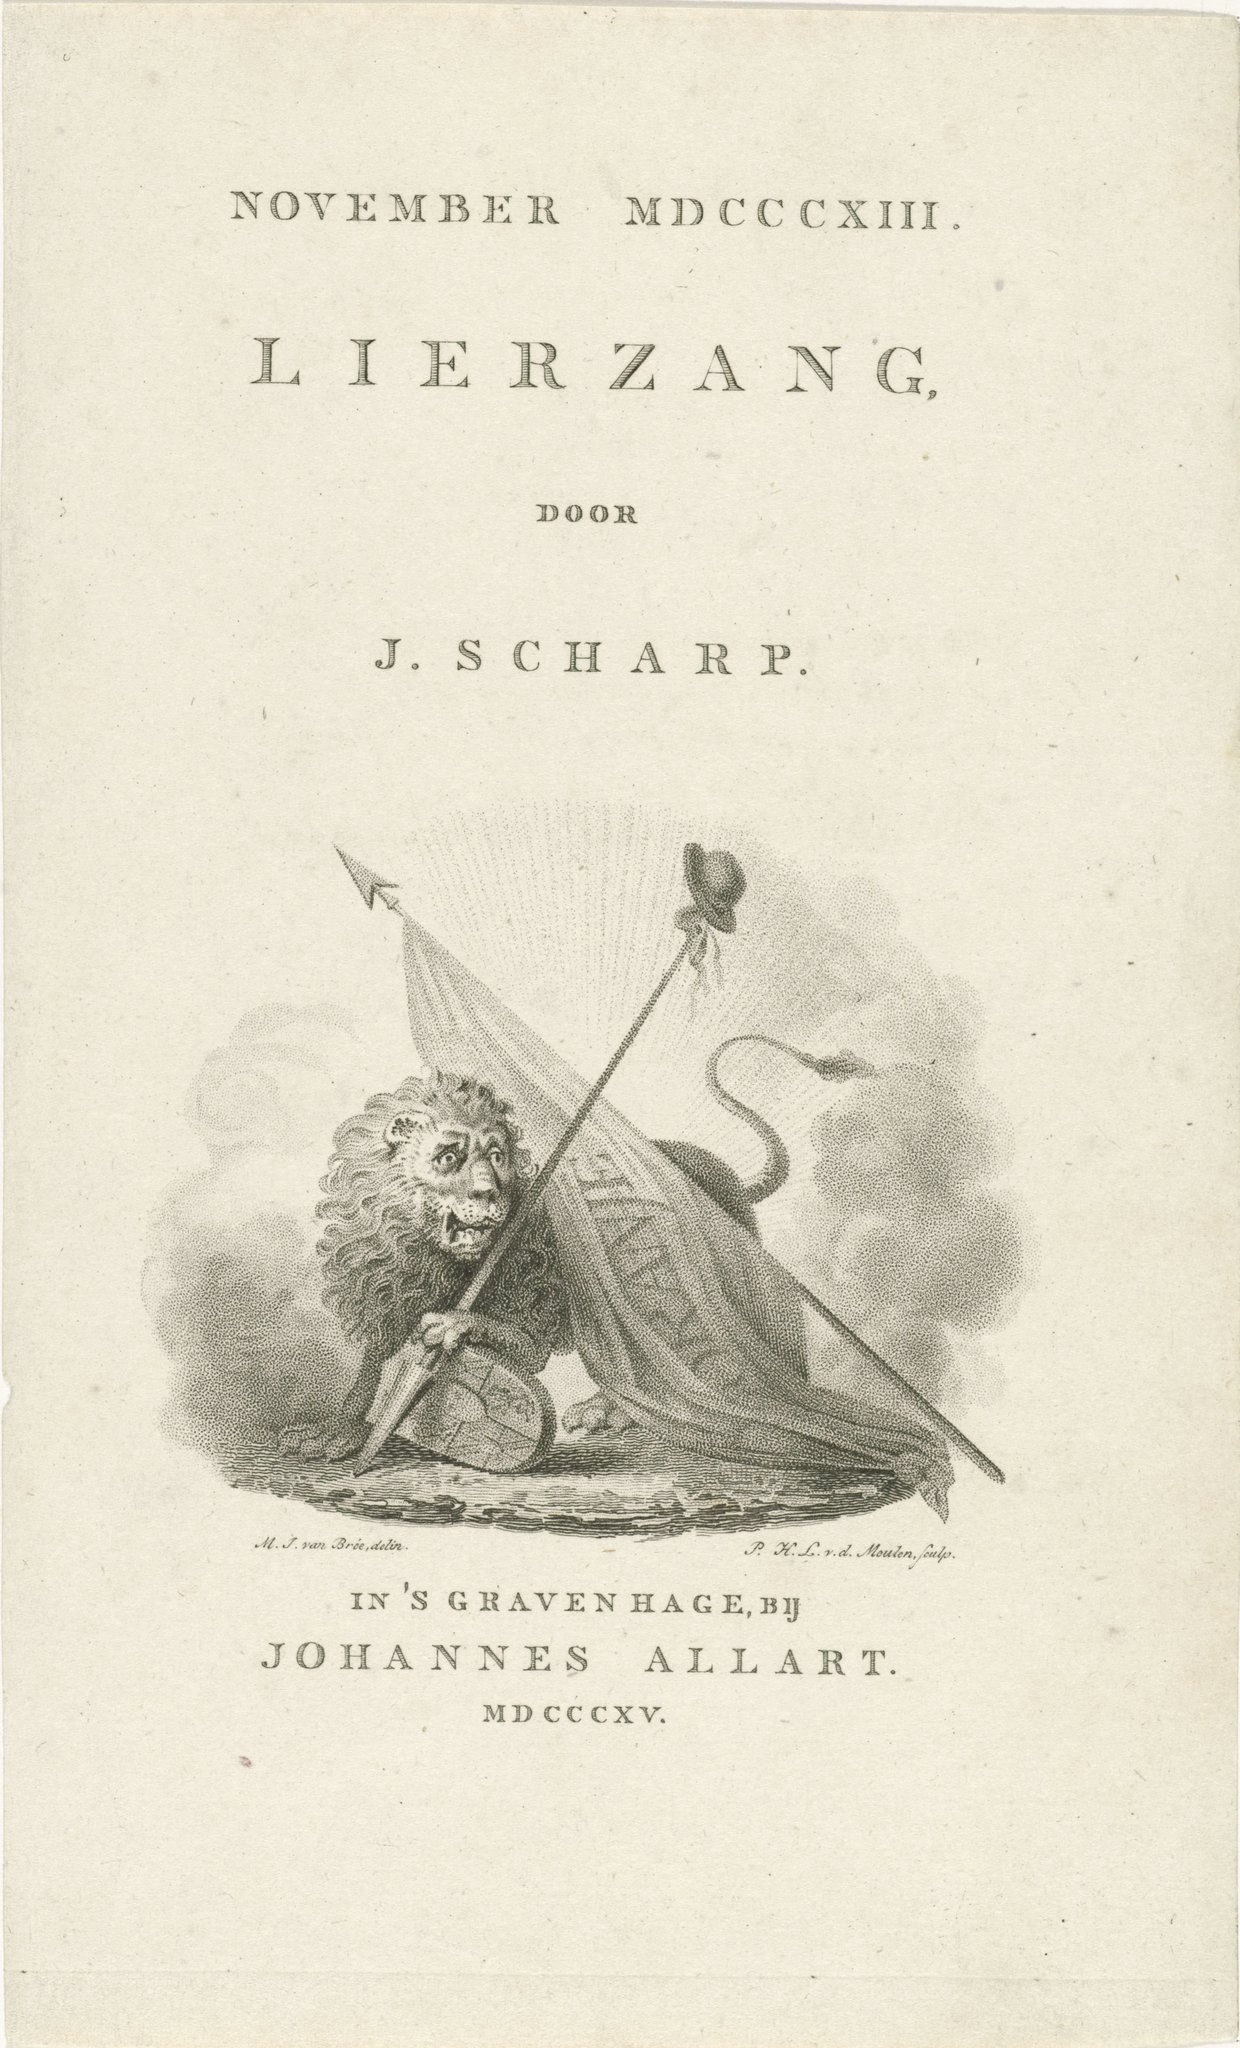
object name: titelblad, titelpagina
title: Hollandse Leeuw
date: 1815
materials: paper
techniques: etching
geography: the hague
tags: beasts of prey, predatory animals: lion, symbols of particular nations, states, districts, etc., freedom, liberty; 'libertà' (ripa) (+ symbolical representation of concept)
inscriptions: collector's mark: Lugt 2228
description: De Hollandse Leeuw met een wapenschild, vrijheidslans en een banier met de tekst: oranje. Allegorie op de terugkeer van prins Willem I in november 1813.